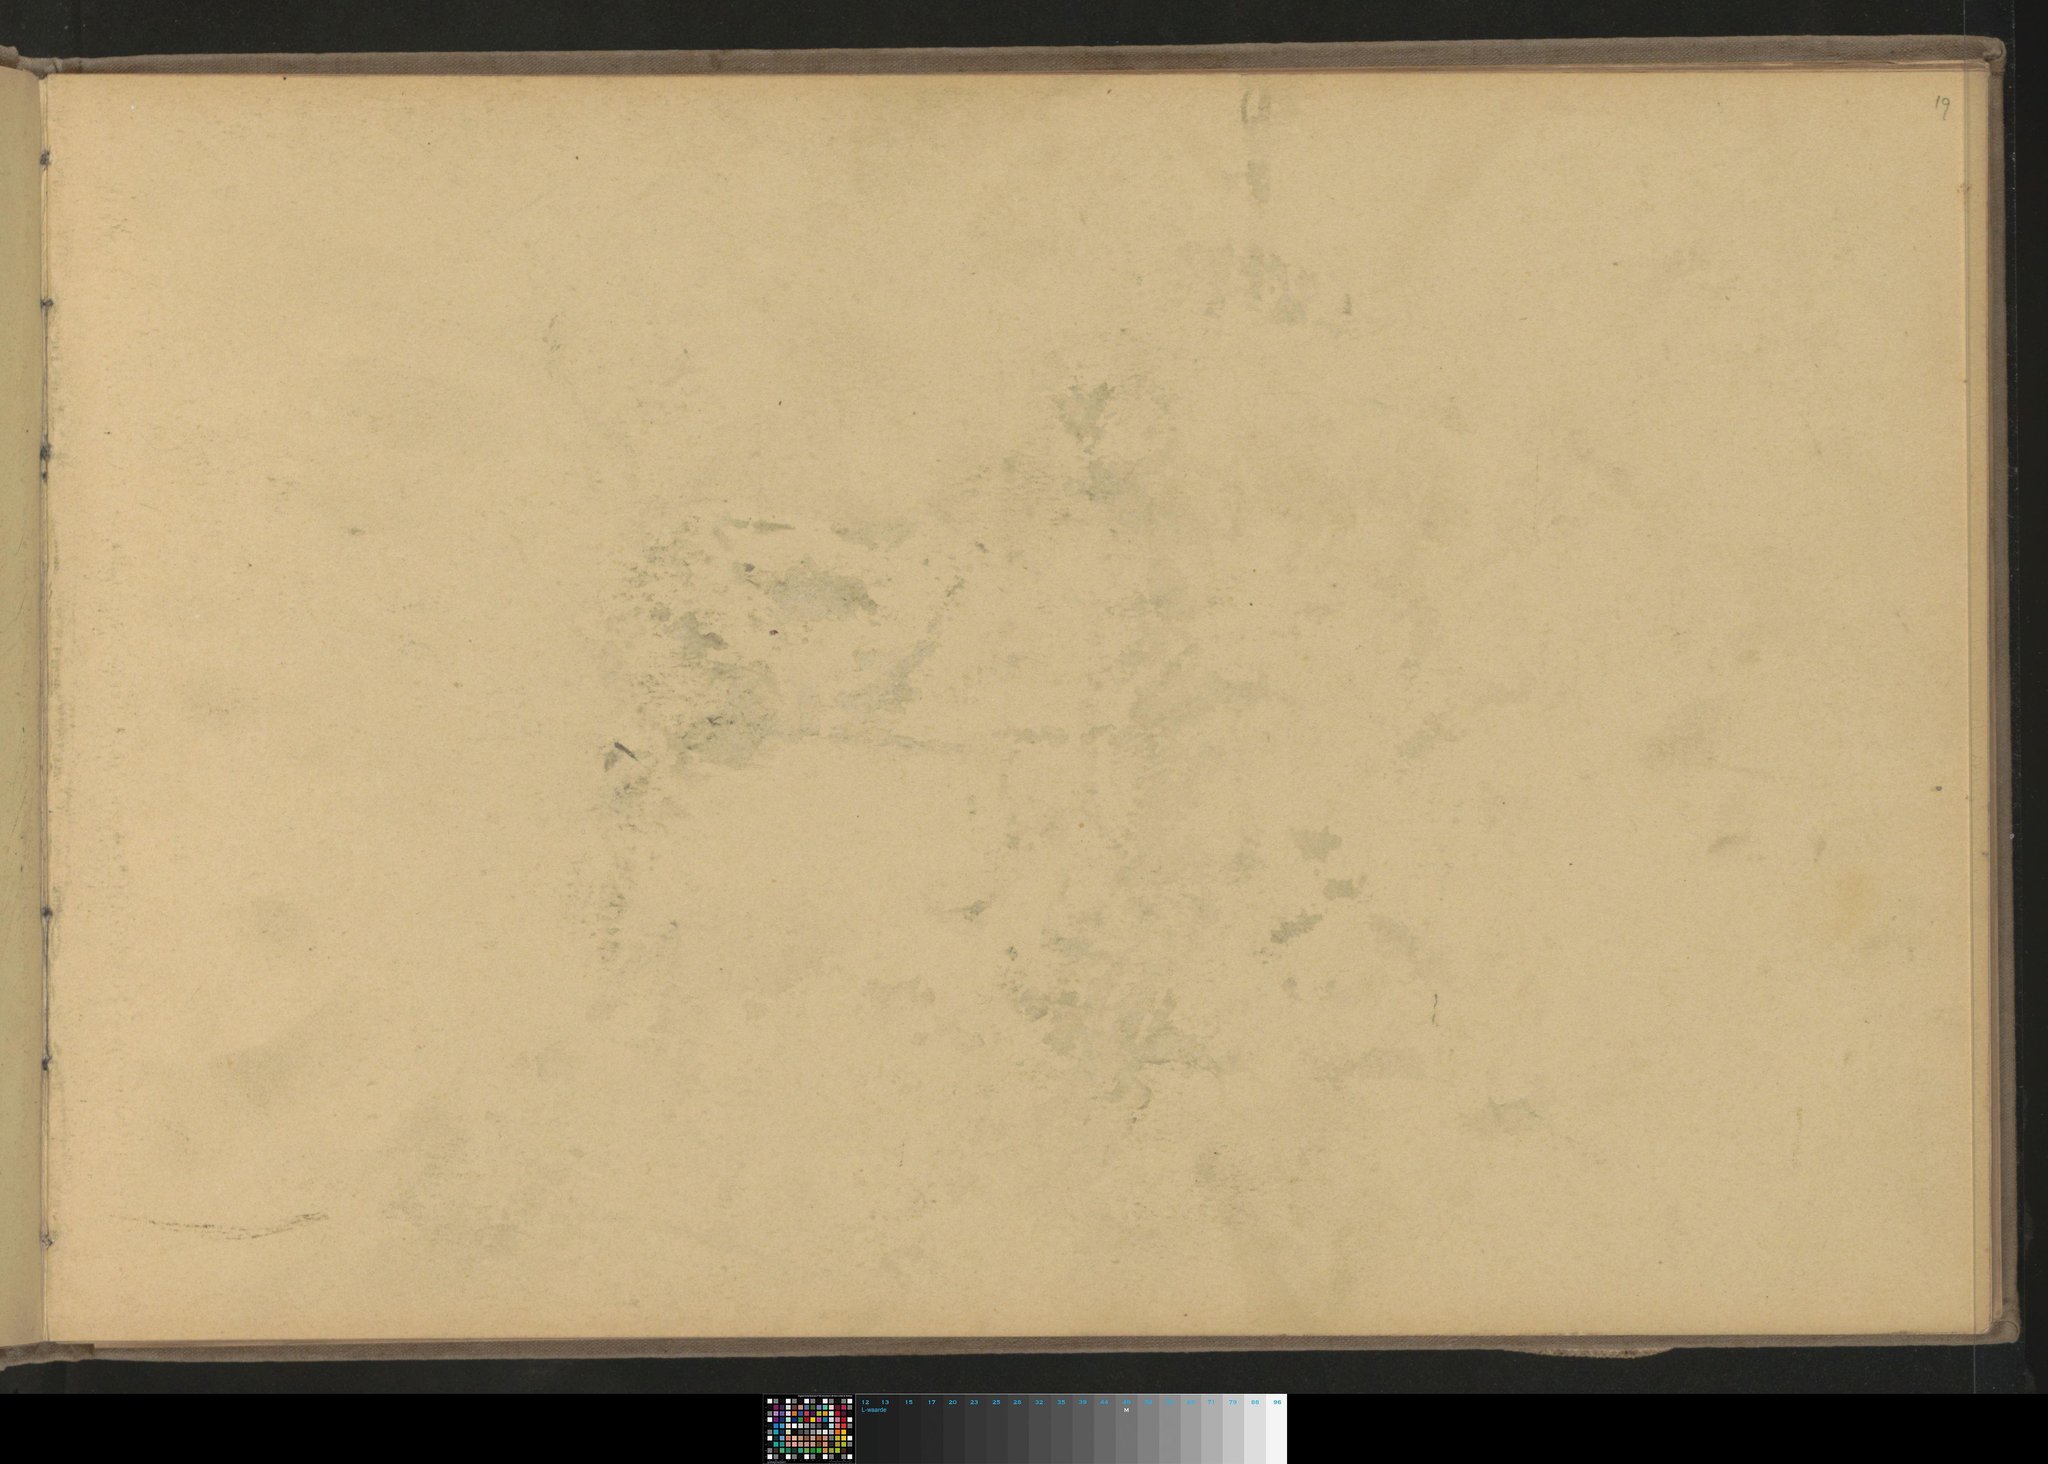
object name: sketchbook leaf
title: Abklatsch van de tekening op pagina 18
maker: willem witsen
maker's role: draughtsman, painter, print maker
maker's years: 1860-1923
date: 1901-1907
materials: paper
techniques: printmaking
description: Pagina 19 uit een schetsboek met 60 bladen.